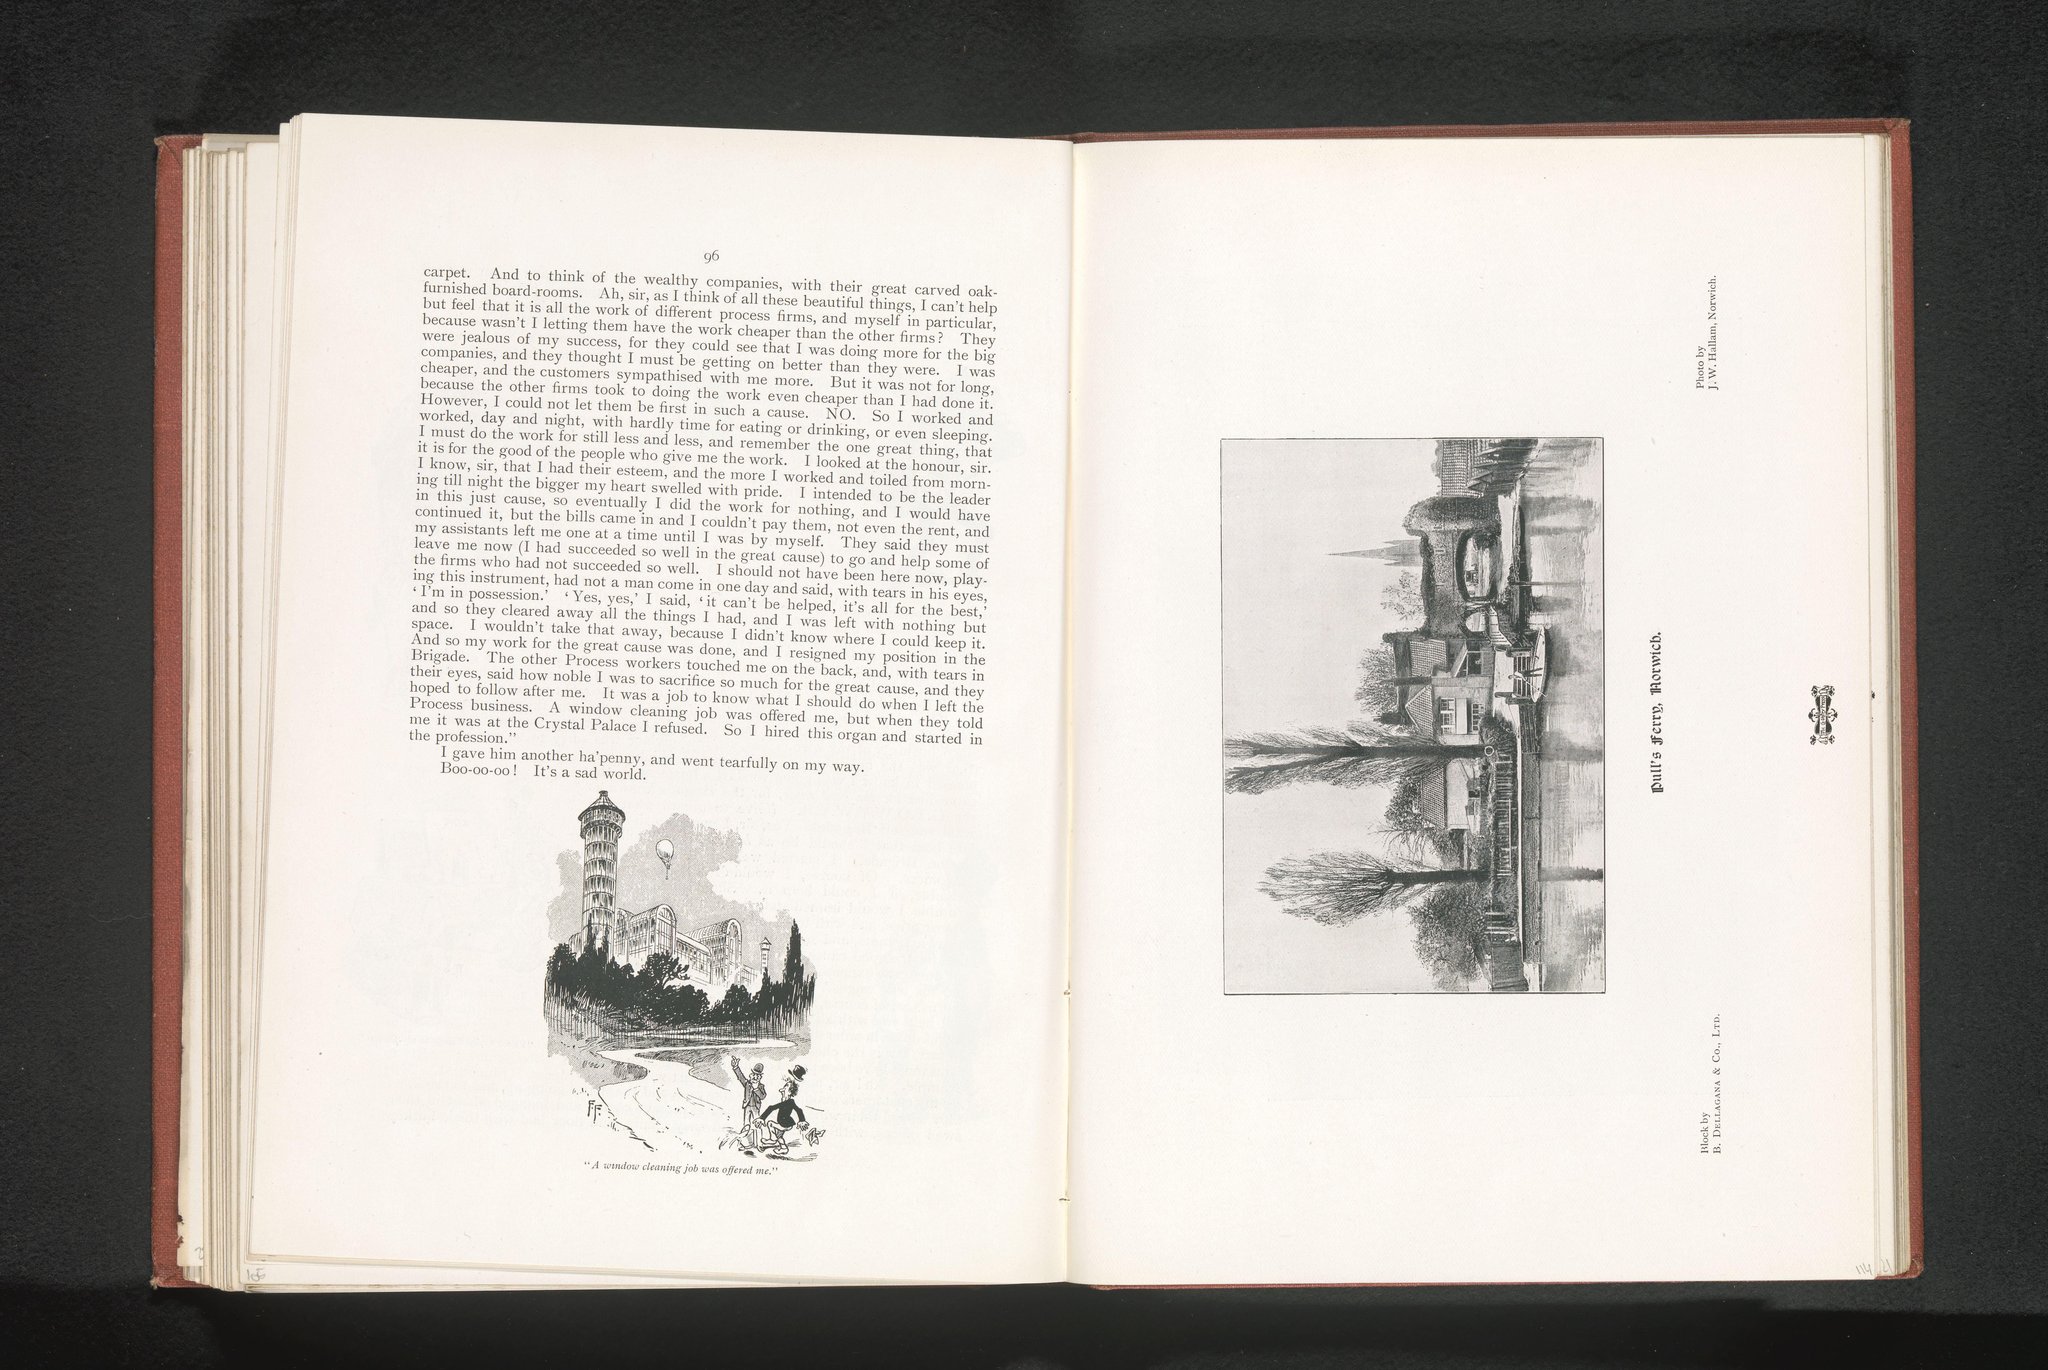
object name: page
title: Pull's ferry, Norwich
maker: j.w. hallam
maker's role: fotograaf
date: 1895-1900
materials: paper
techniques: autotype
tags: ferry, village (+ city(-scape) with figures, staffage)